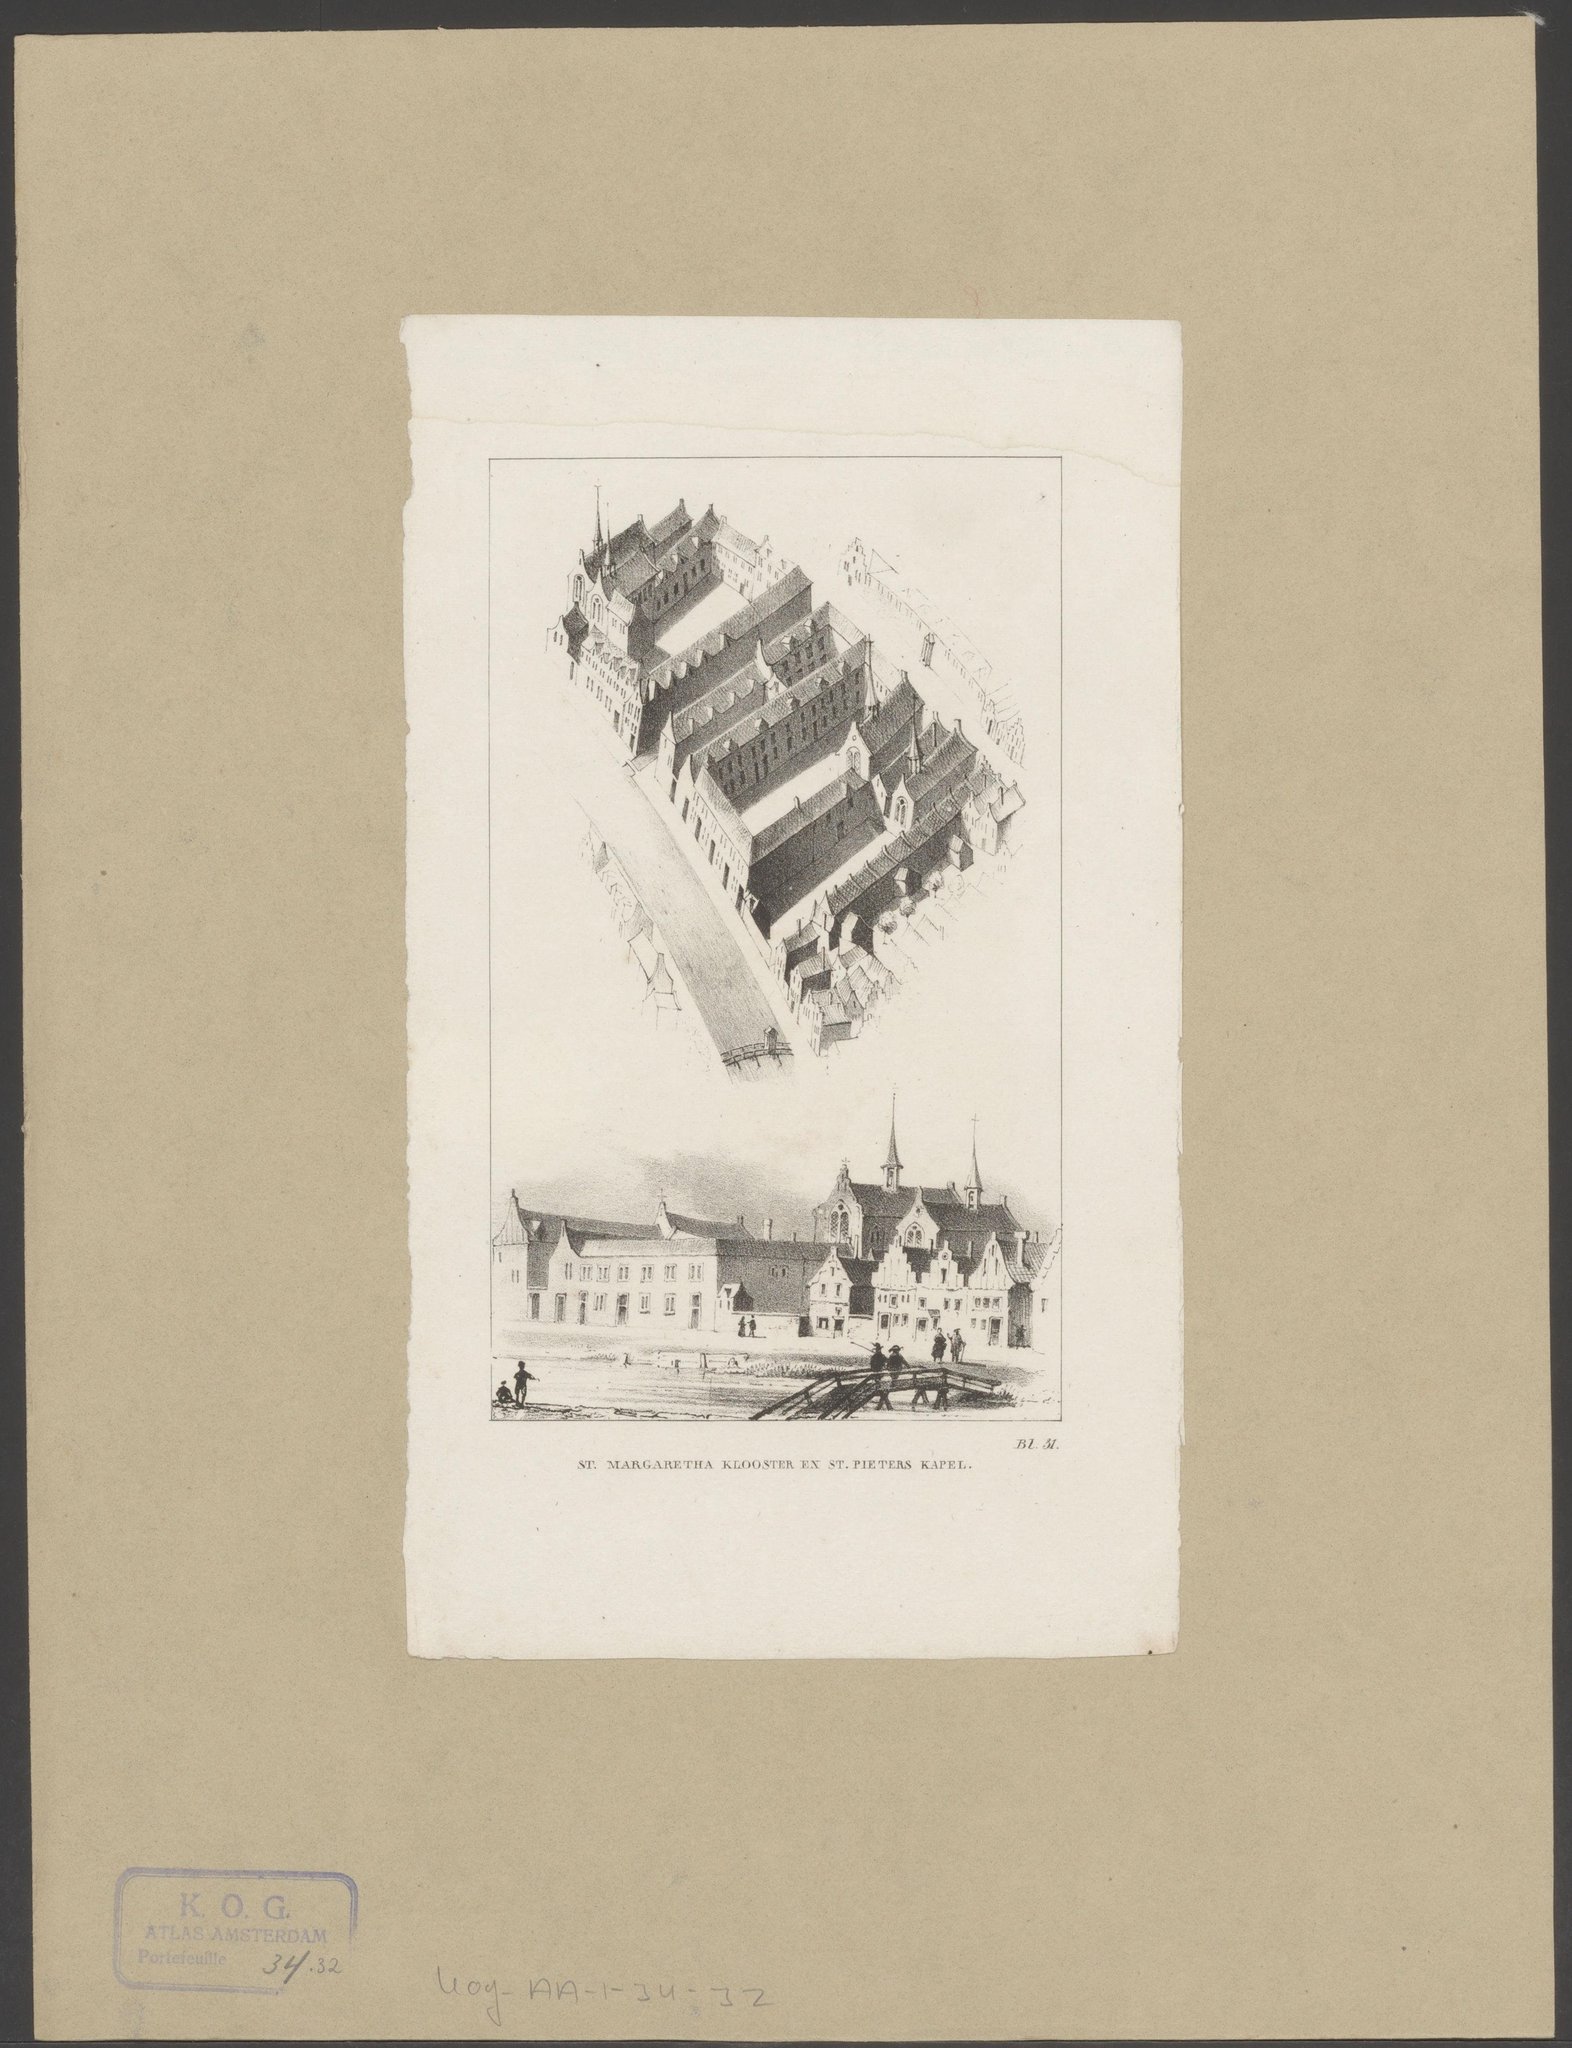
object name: book illustration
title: St. Margaretha klooster en St. Pieters kapel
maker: johannes hilverdink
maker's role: draughtsman, painter, print maker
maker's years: 1813-1902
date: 1844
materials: paper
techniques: lithograph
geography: amsterdam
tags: abbey, monastery, convent ~ roman catholic church, church (exterior) - qq - small church, chapel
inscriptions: collector's mark: Lugt 1641b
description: Gezicht in vogelvlucht en gezicht op het Sint-Margarethaklooster en de Sint-Pieterskapel, de kapel van het Sint-Pietersgasthuis, tussen de Nes en de Oudezijds Voorburgwal te Amsterdam, in de situatie omstreeks 1544. Rechtsonder: Bl. 31. Onderwerpsrubriek binnen de Atlas Amsterdam: Kerkwezen: R.K. Gemeenten: Kloosters.